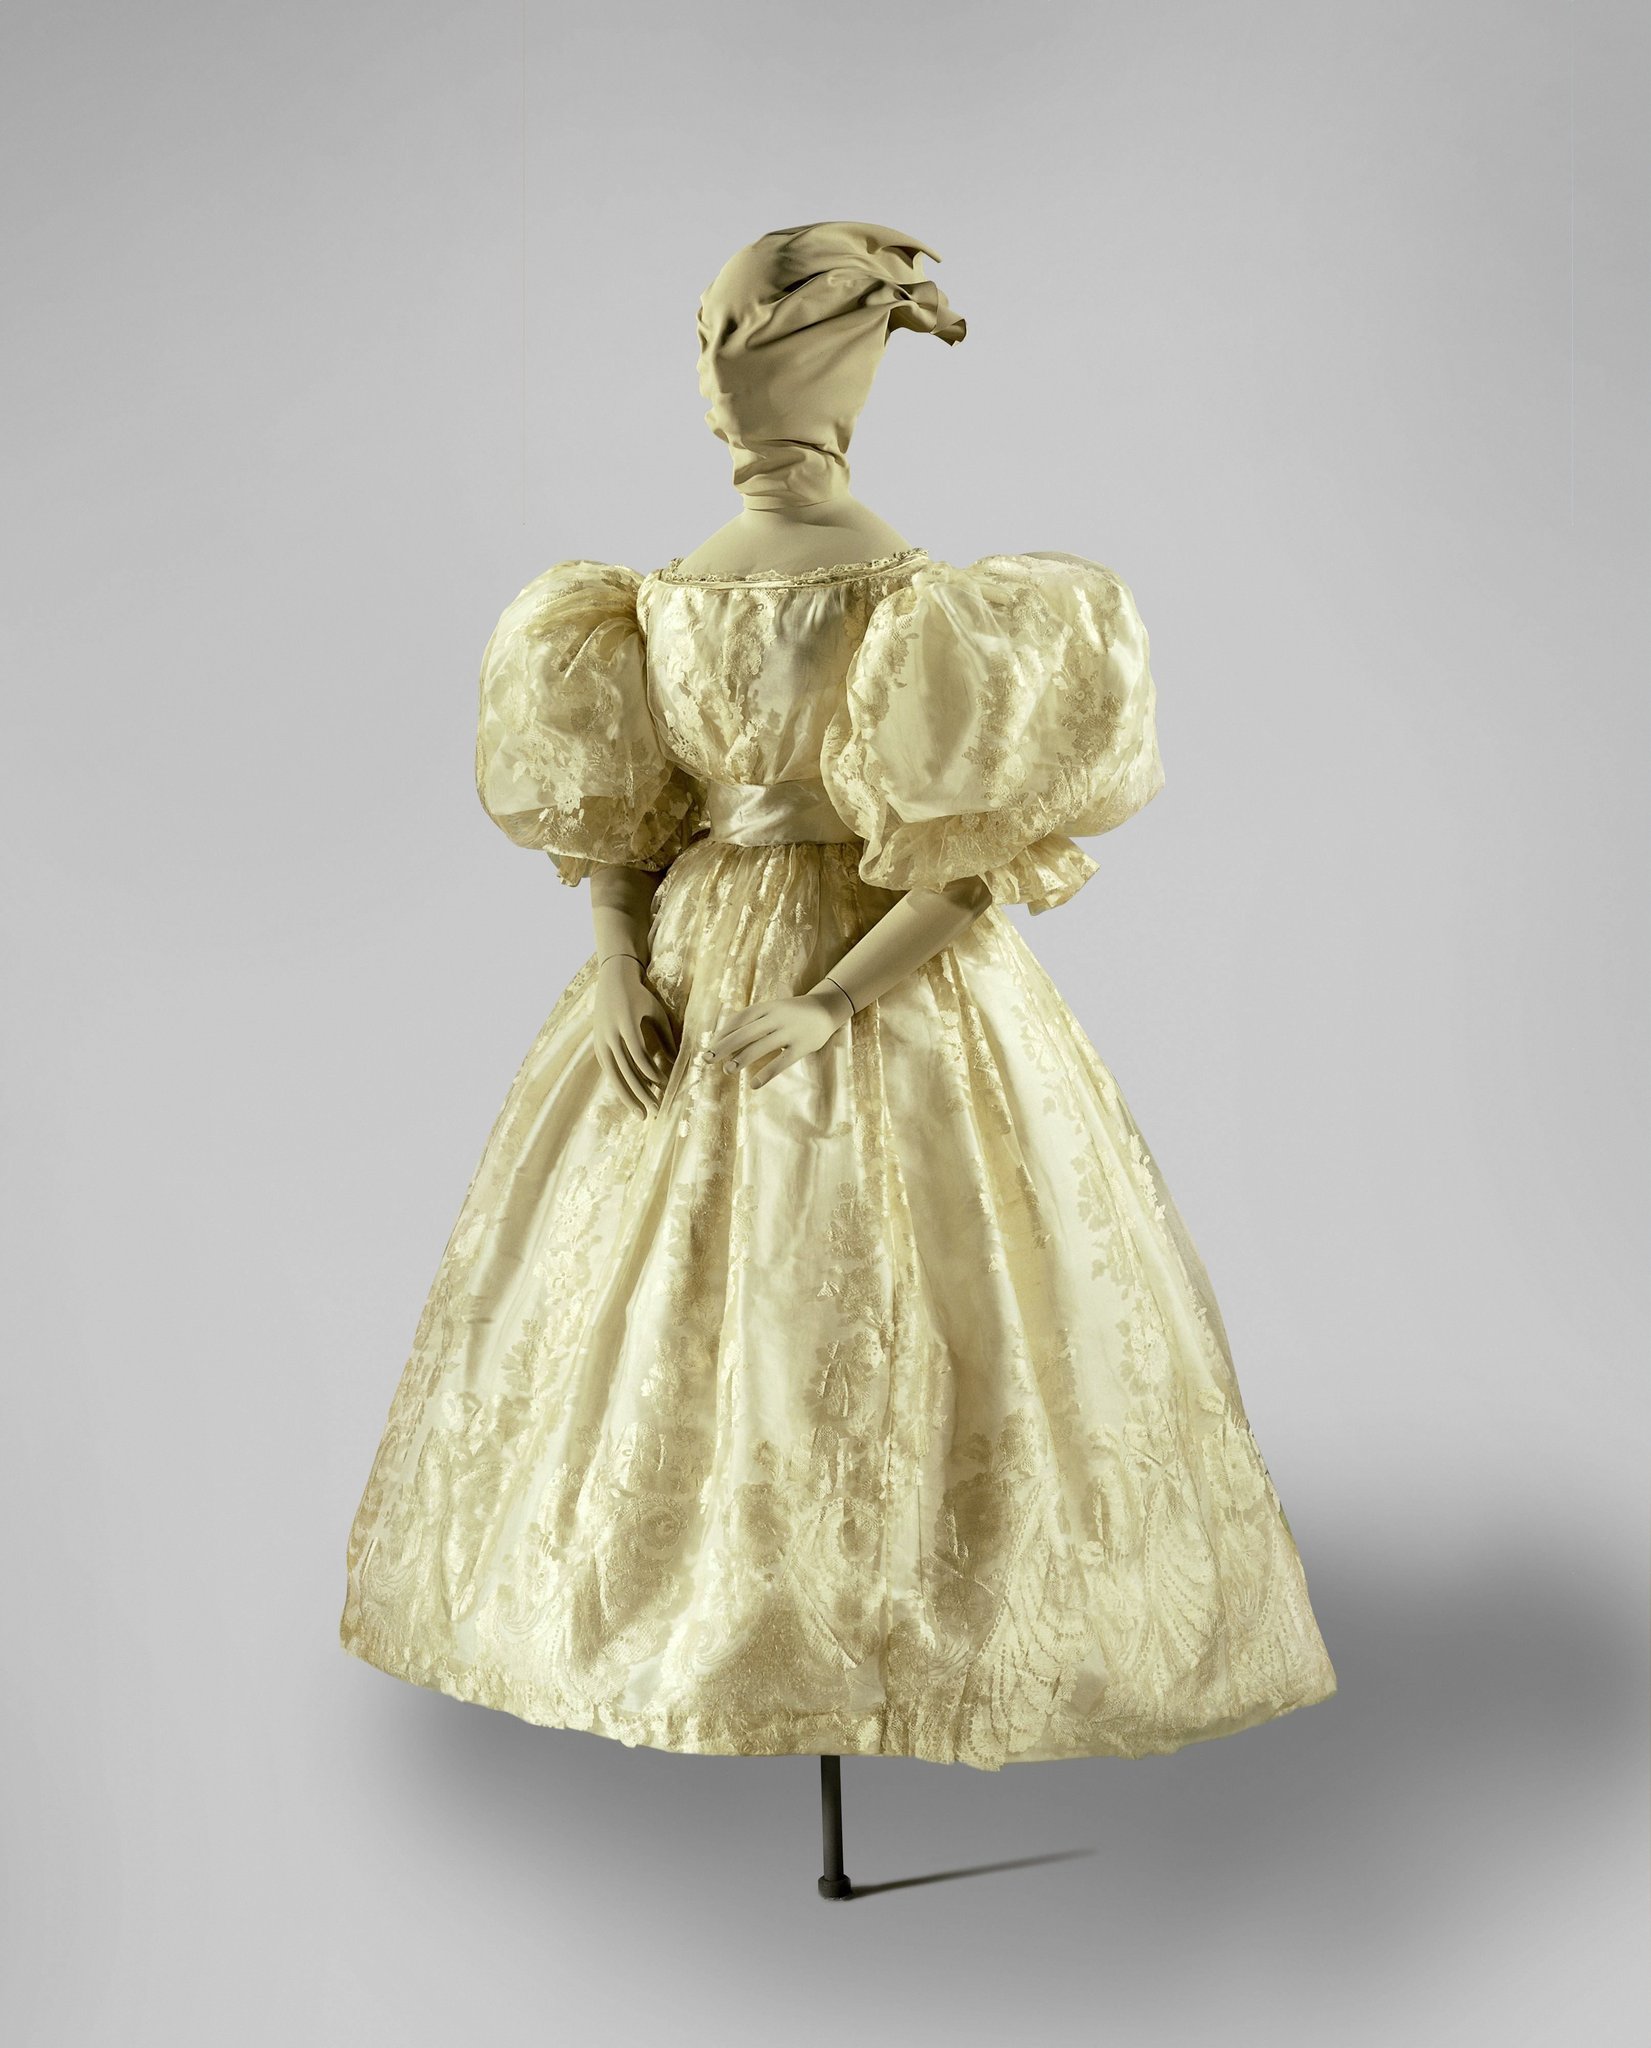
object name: stocking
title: Wedding dress with extremely wide, puffed sleeves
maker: Anonymous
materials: silk, textile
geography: netherlands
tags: amsterdam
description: In 1835 Baroness Nine van Slingelandt married Jonkheer Pieter Teding van Berkhout in Amsterdam. Unlike many of her wealthy contemporaries she did not wear a lace dress, but rather a wedding gown made of an intricately woven silk fabric that makes the illusion of lace. The fabric consists of a tulle ground to which extra threads were added to create the floral pattern.